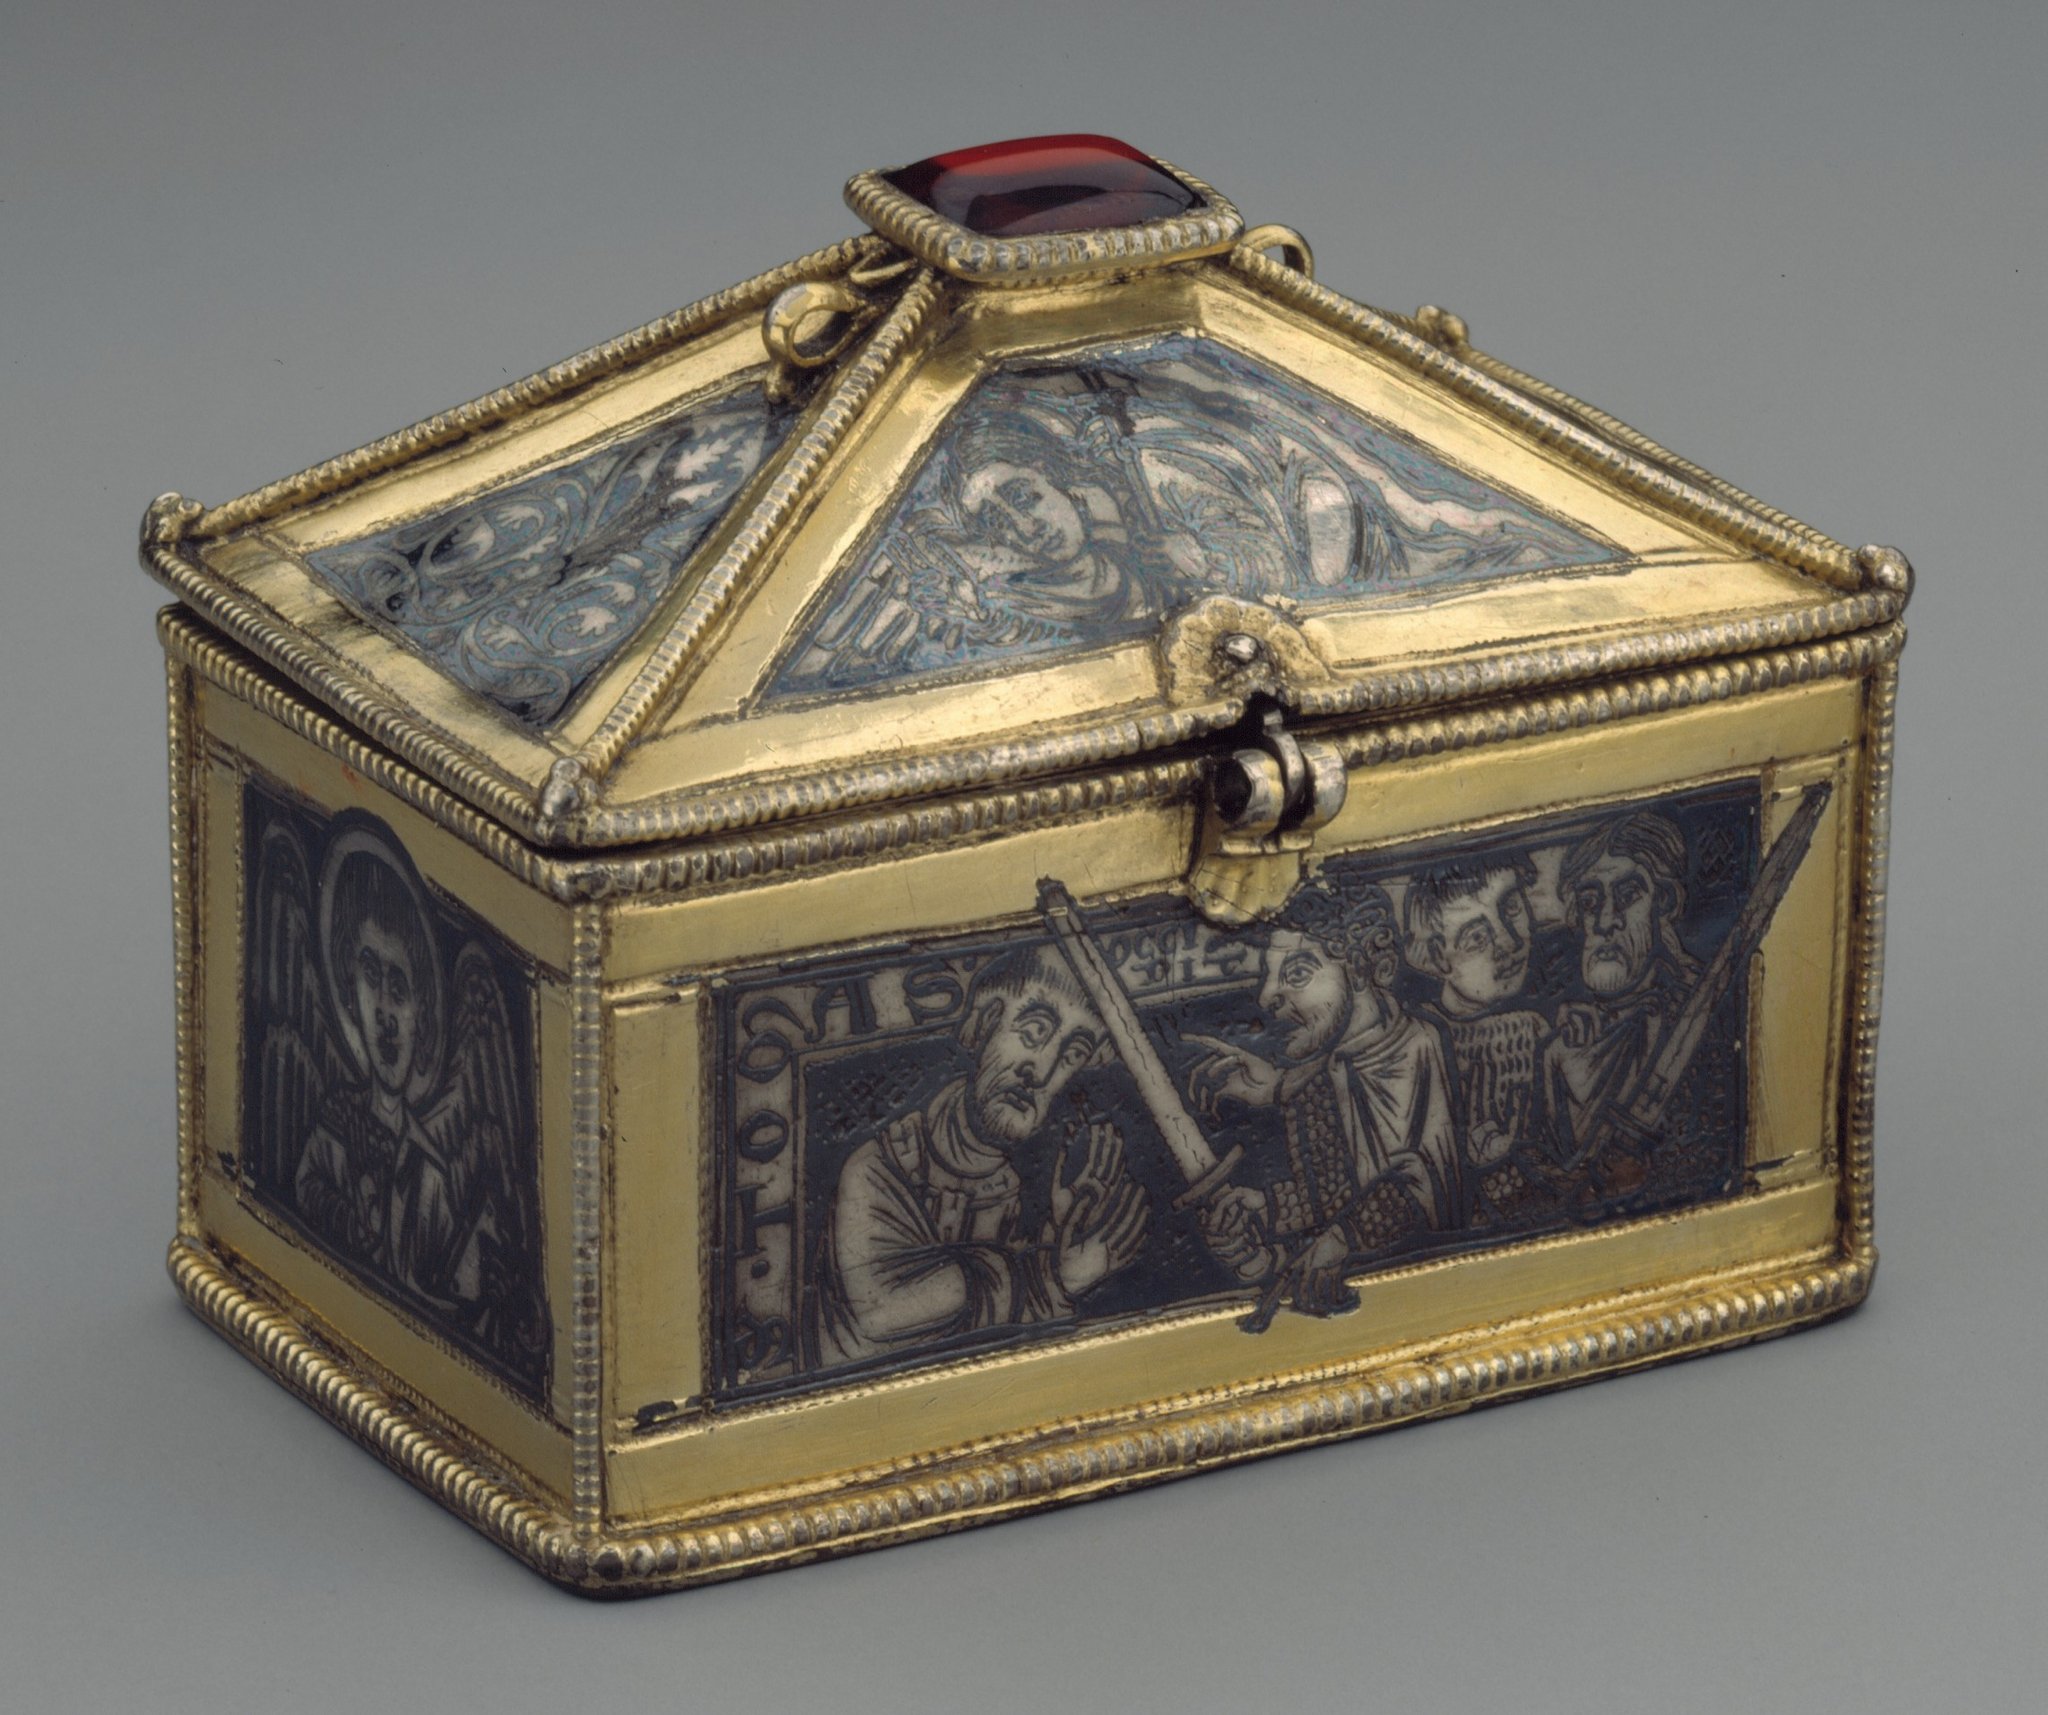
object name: reliquary box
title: Reliquary Casket with Scenes from the Martyrdom of Saint Thomas Becket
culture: british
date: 1173-1180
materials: foil, gilt silver, glass, niello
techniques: tinting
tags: men,angels,saints